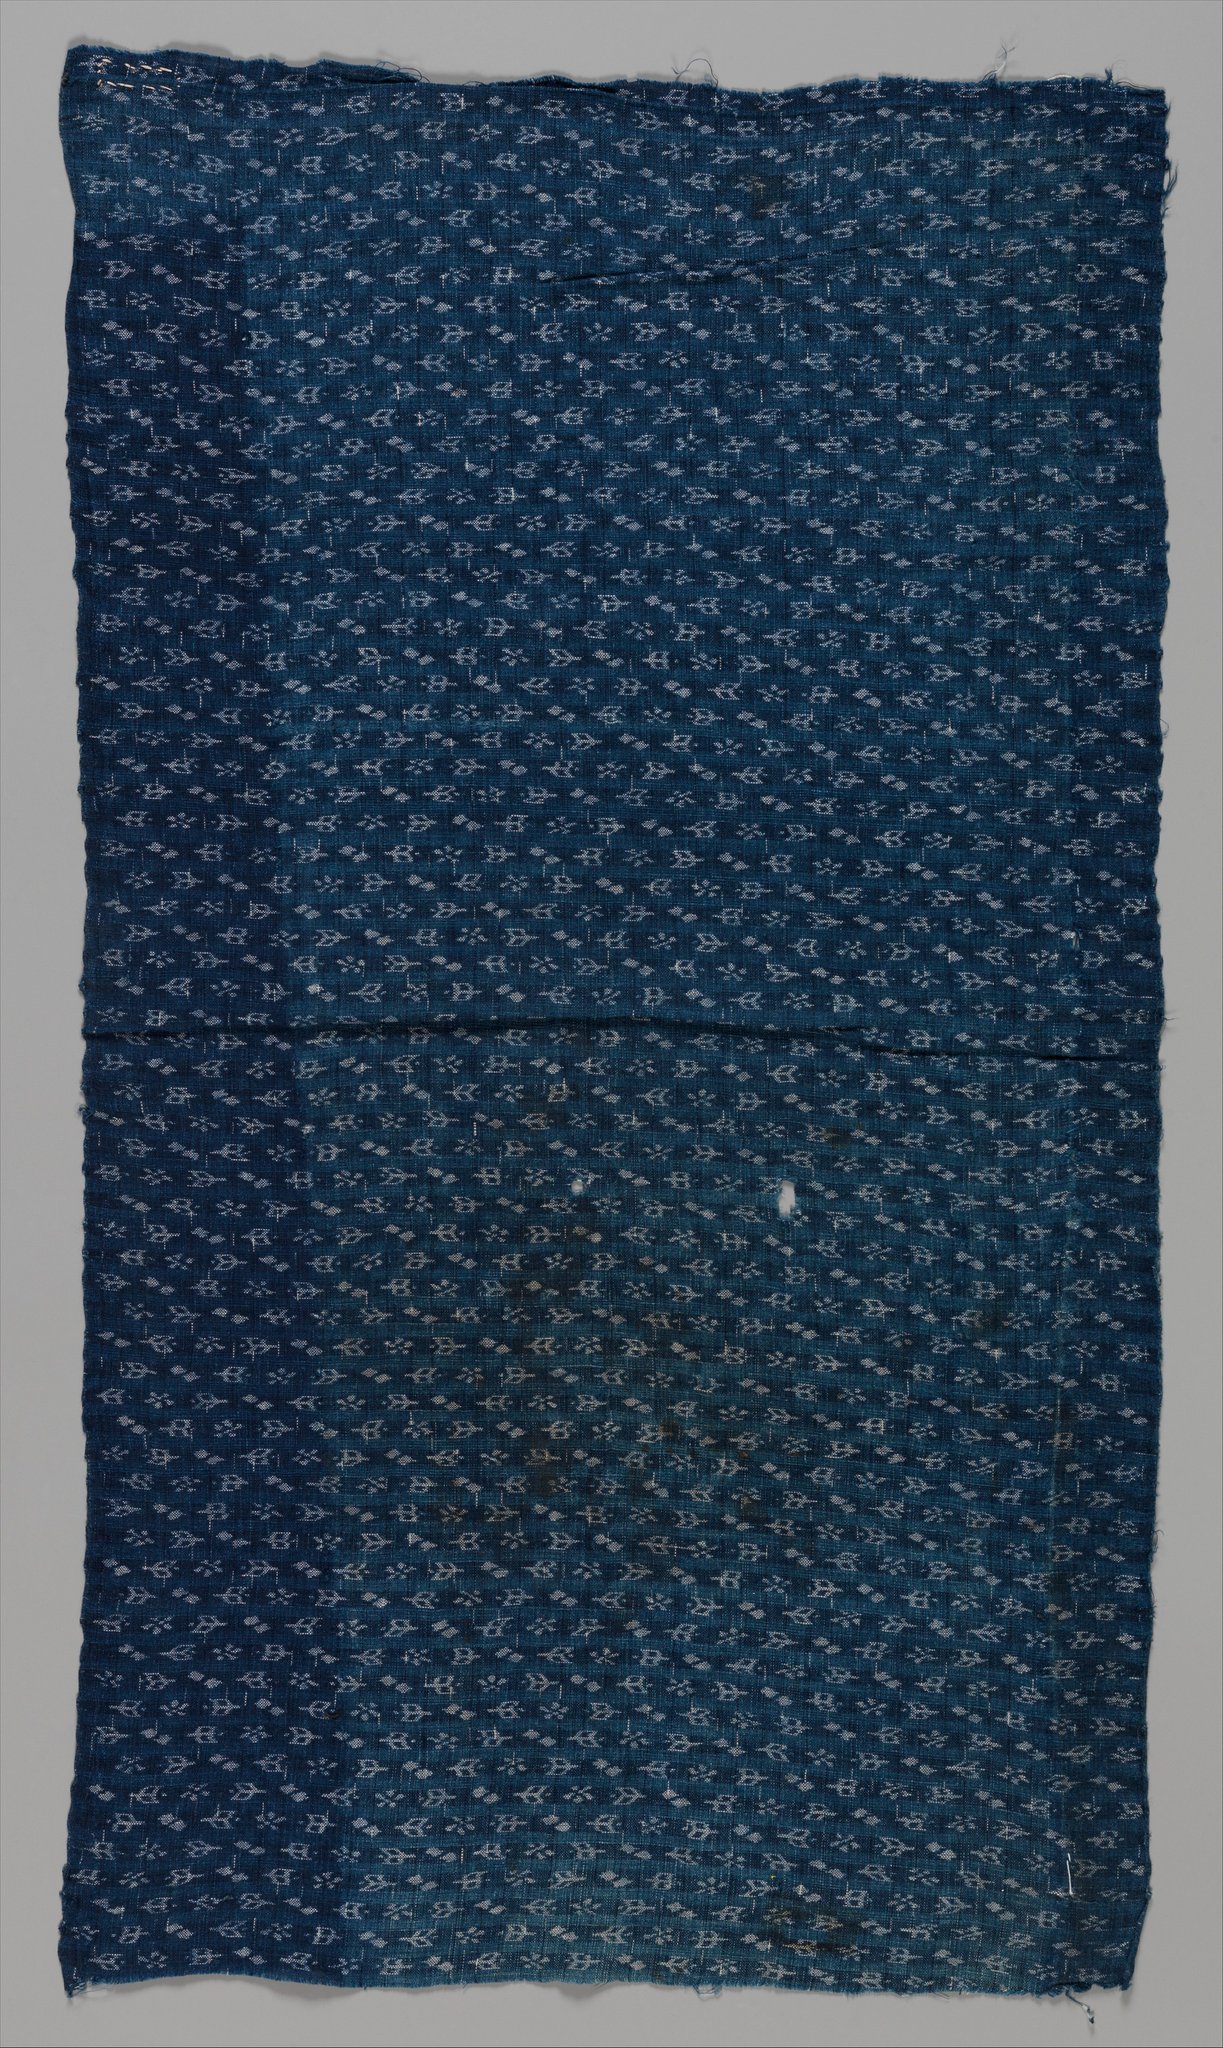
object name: piece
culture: japanese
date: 1801-1900